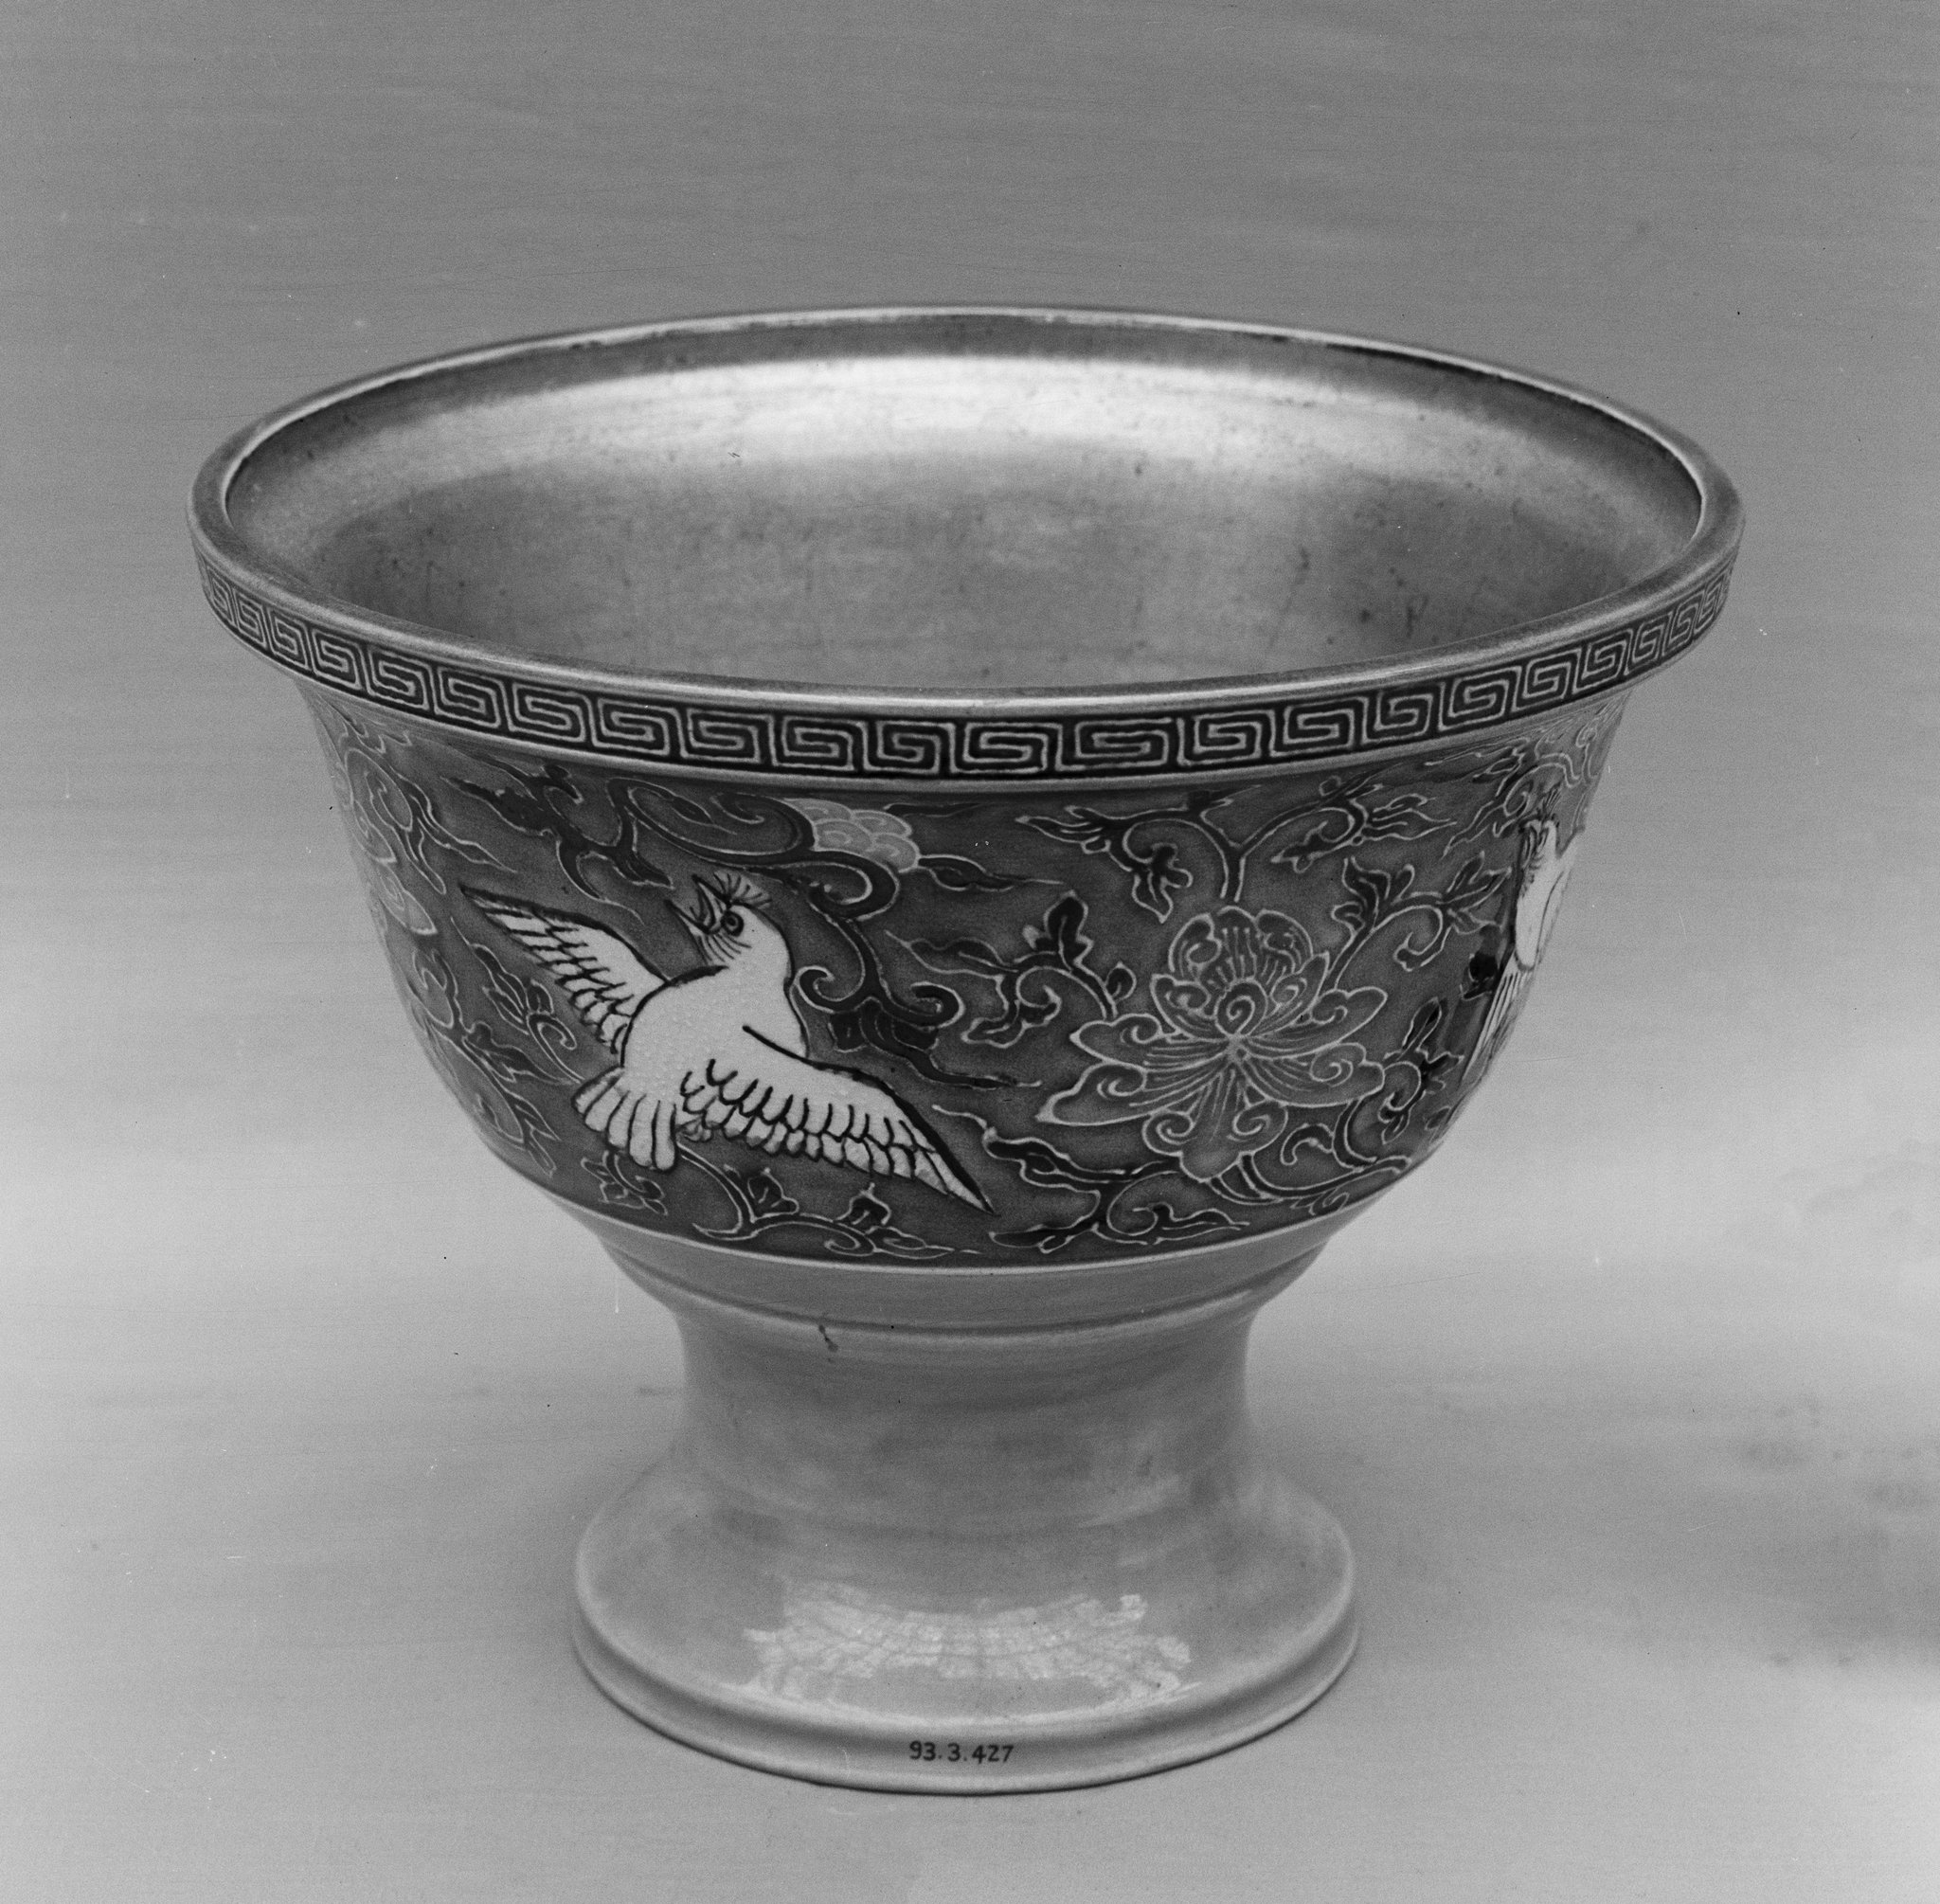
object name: washer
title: Washer for Wine Cups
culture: japanese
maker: eiraku hozen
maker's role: artist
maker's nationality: japanese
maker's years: 1795-1854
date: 1800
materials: clay, glaze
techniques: relief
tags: birds